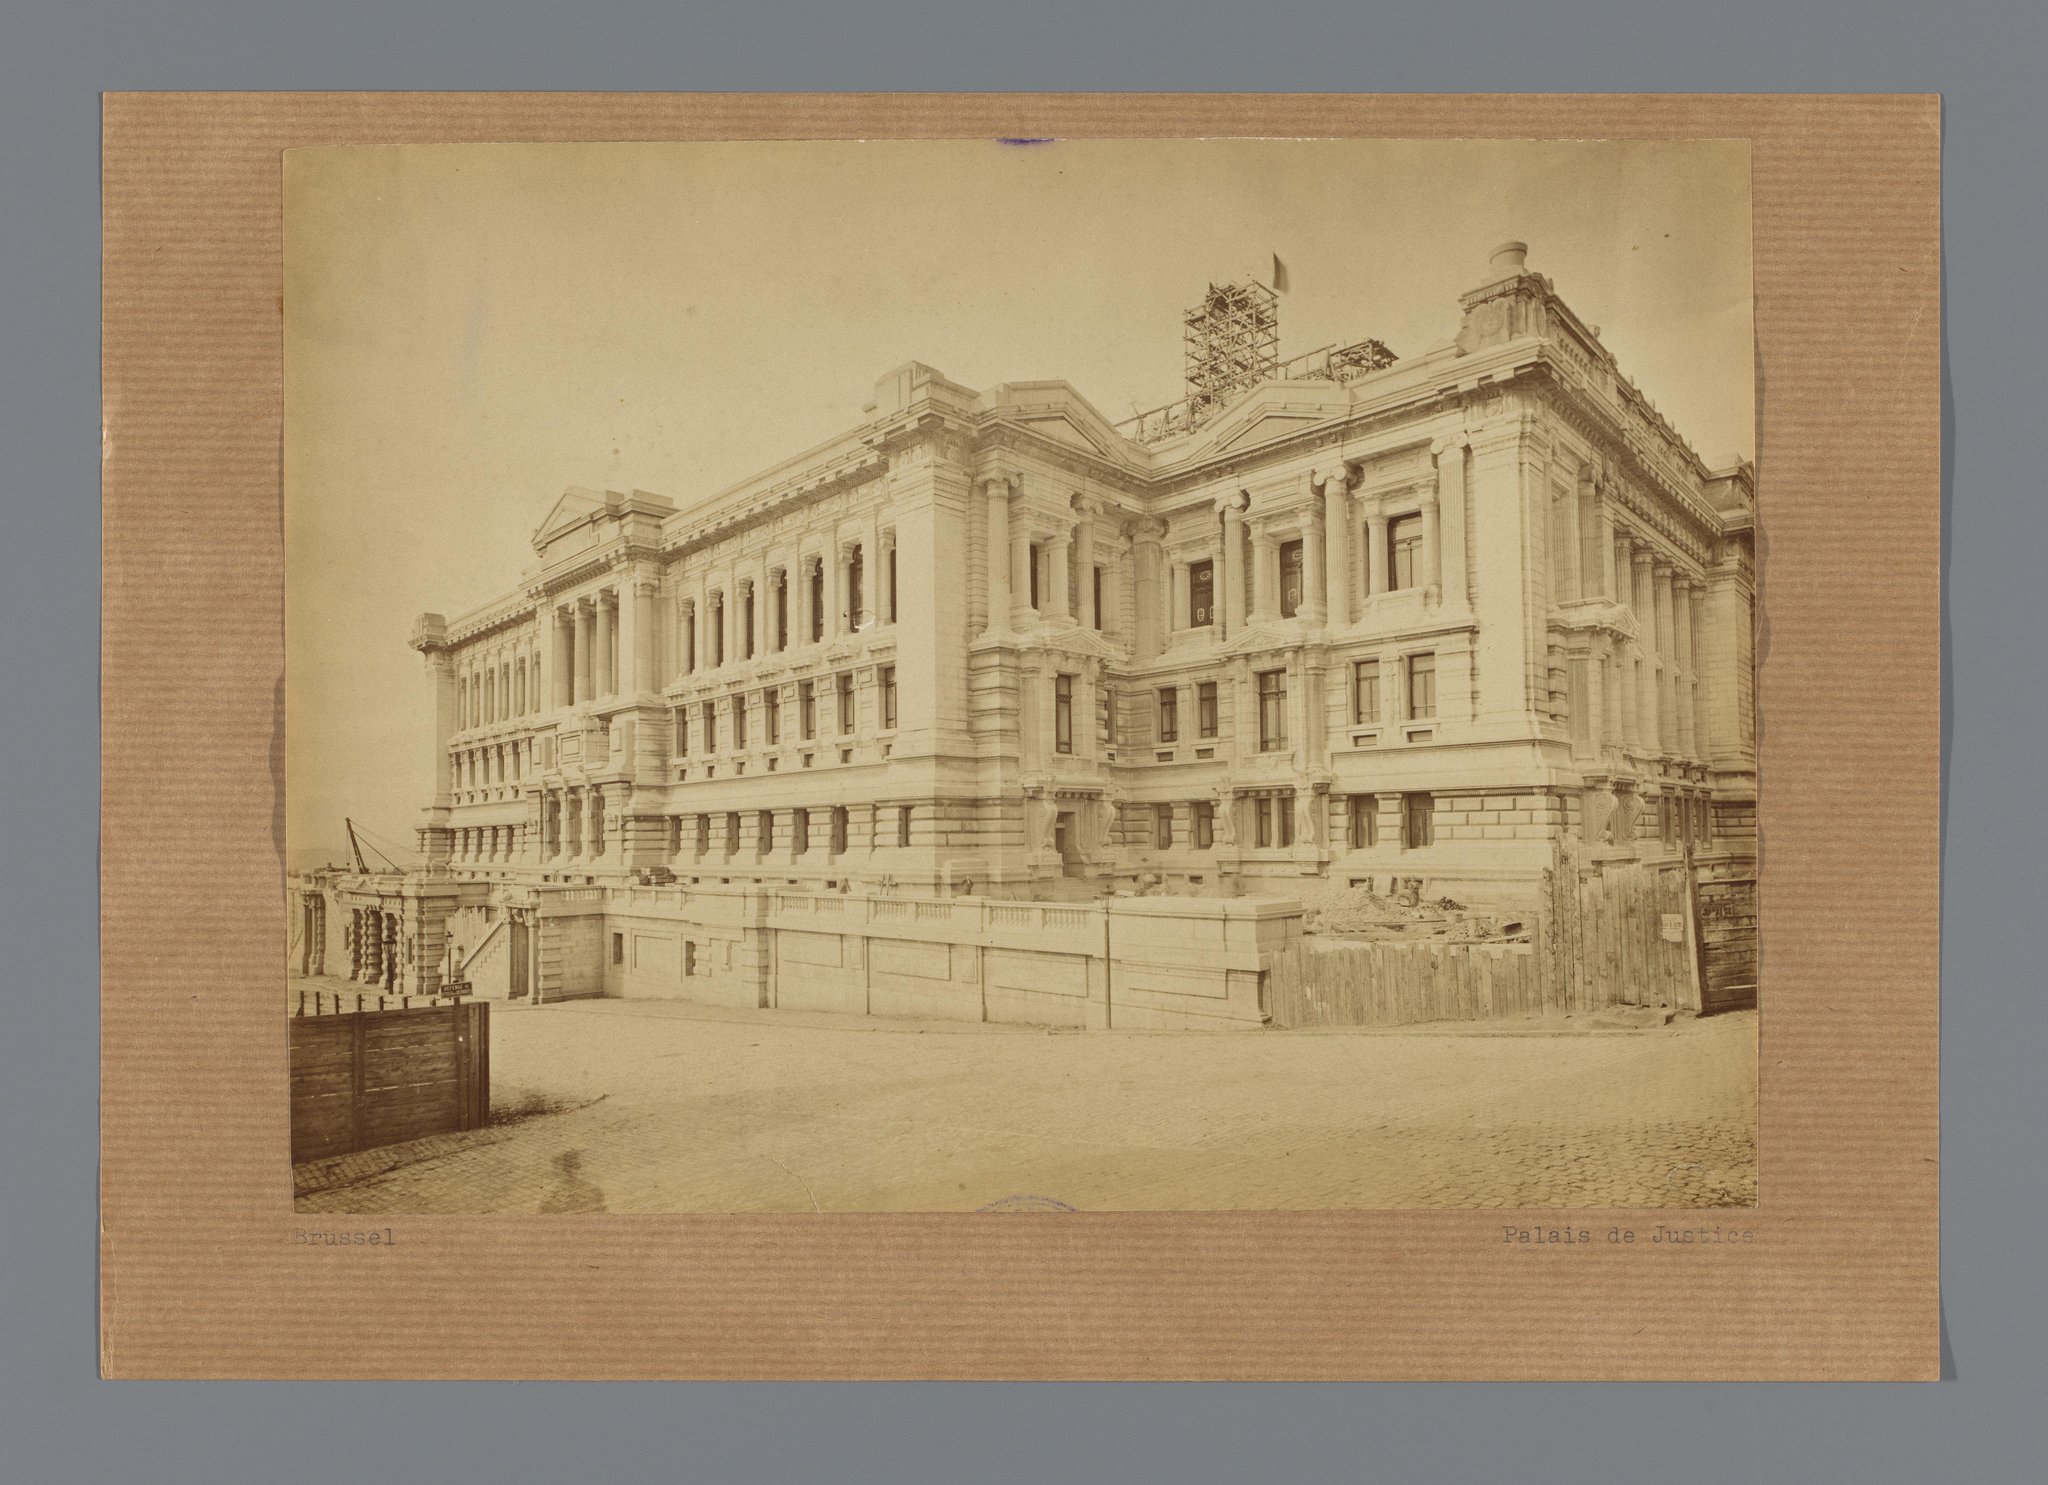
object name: photograph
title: Palais de Justice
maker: Anonymous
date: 1850-1900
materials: photographic support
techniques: albumen print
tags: belgium